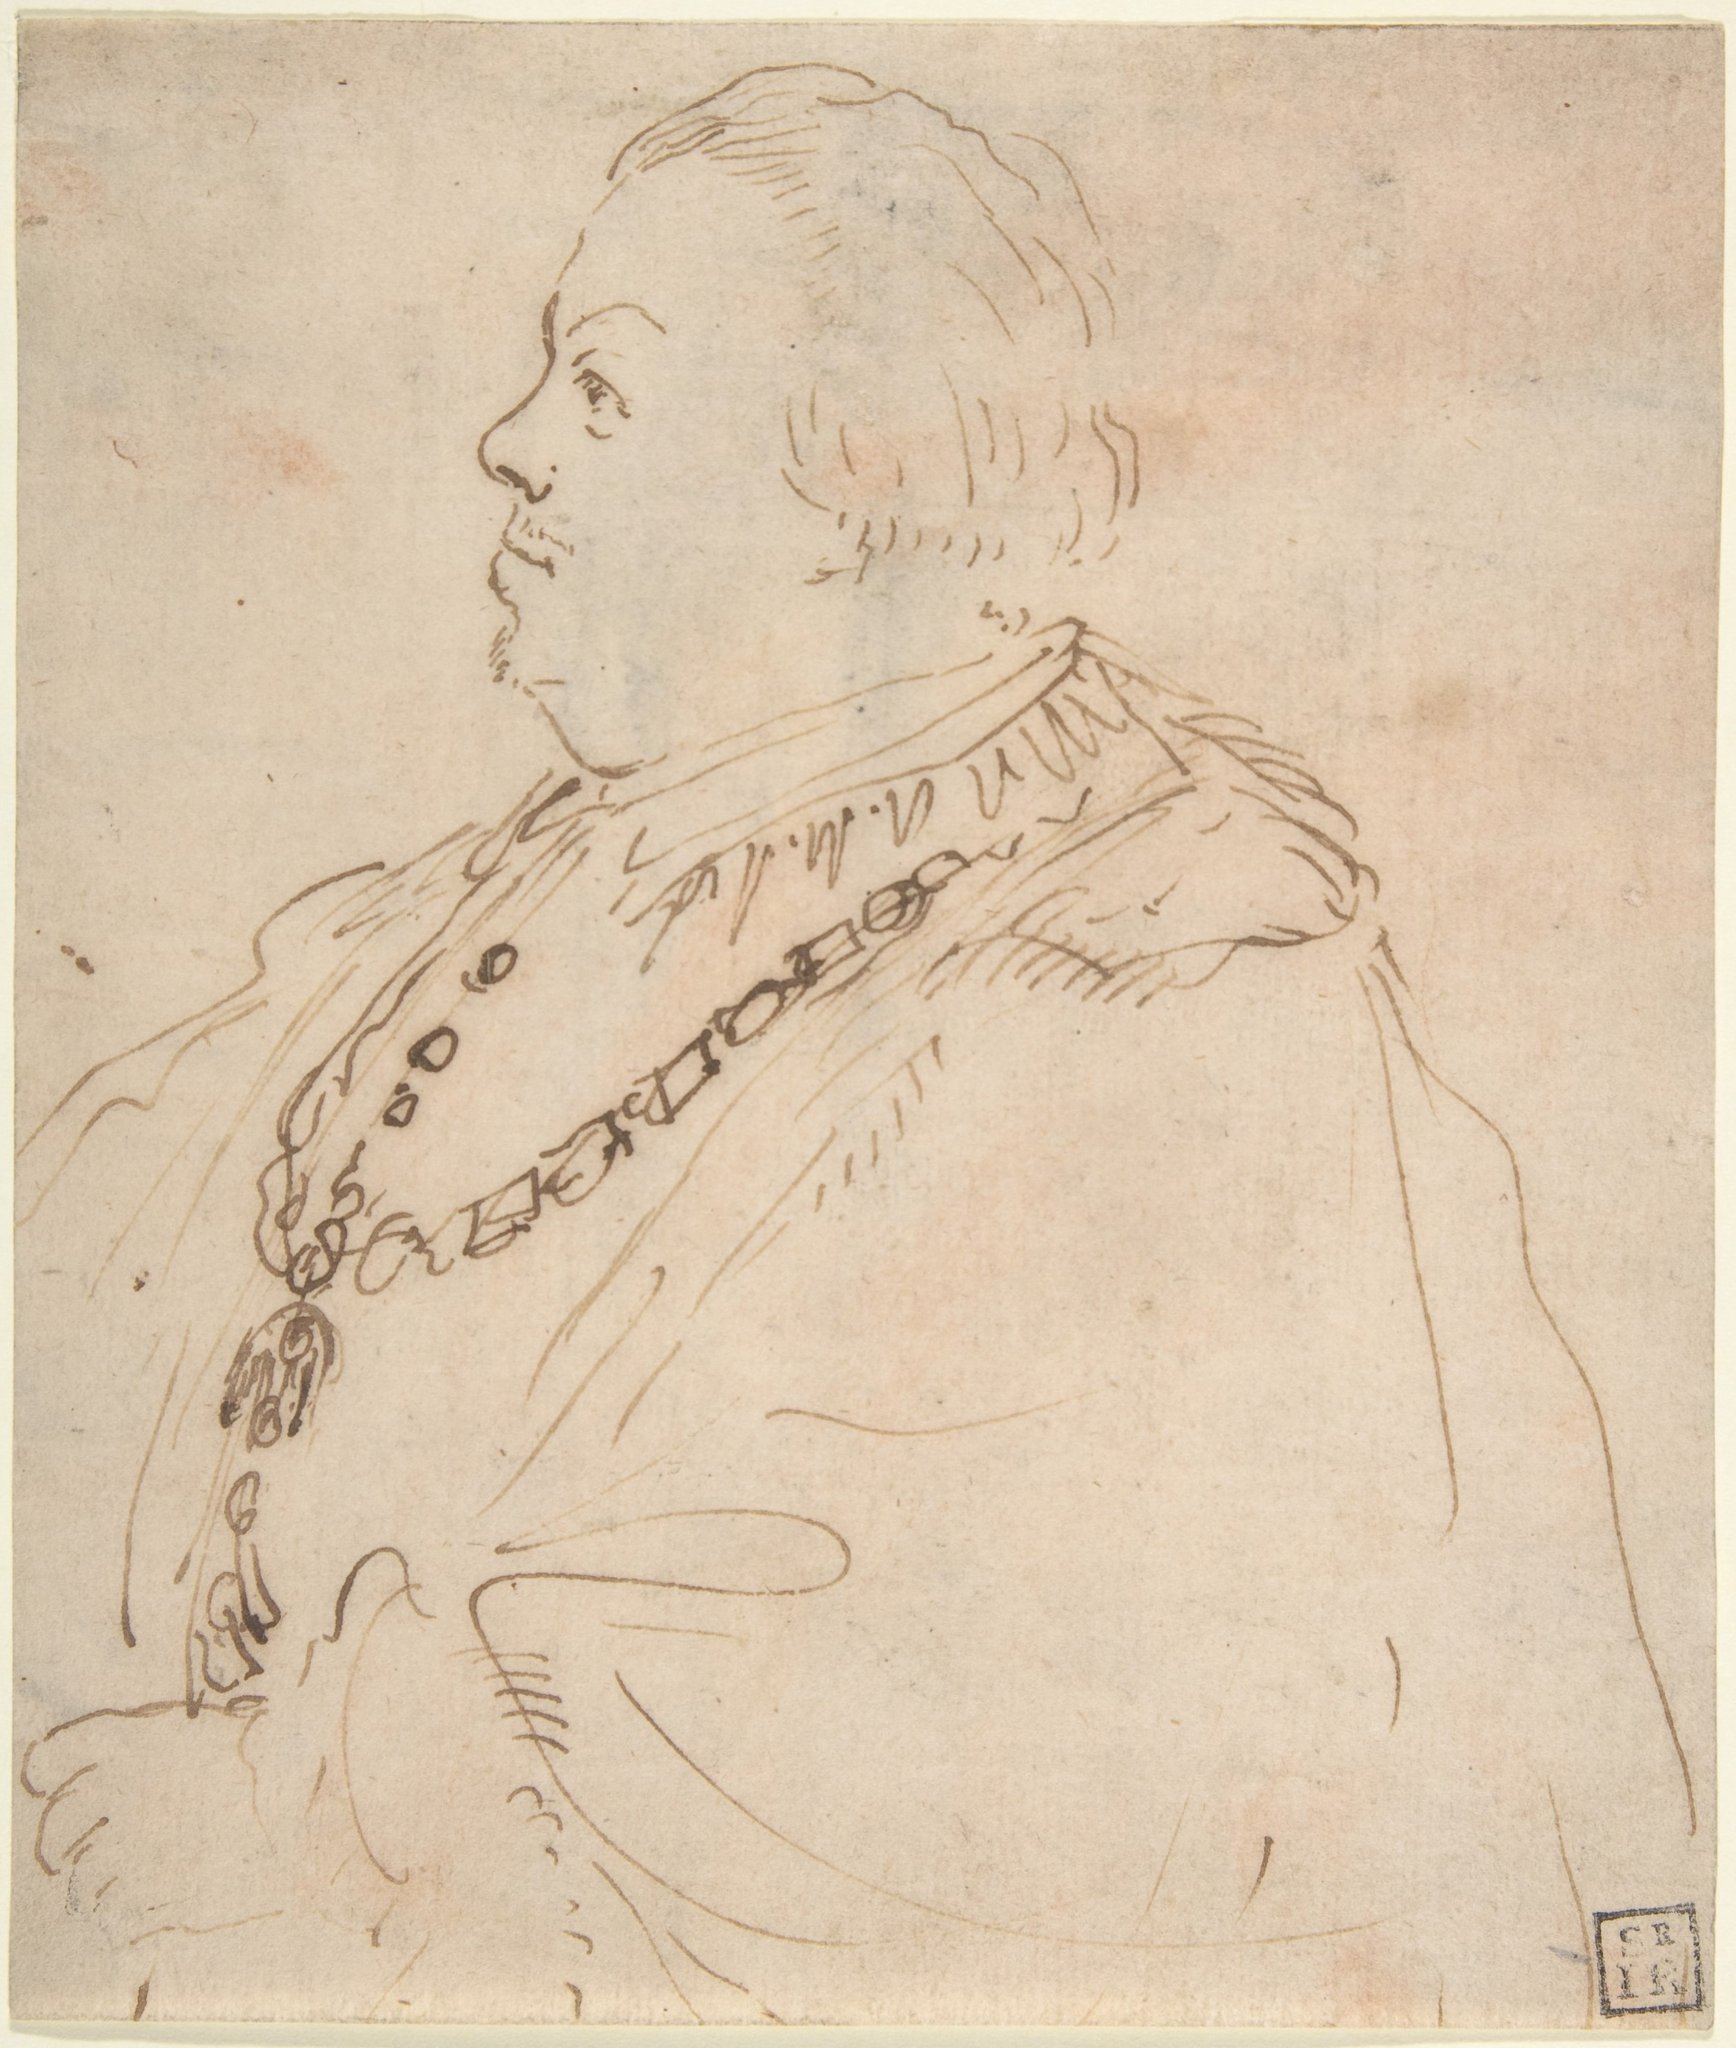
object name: drawing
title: Waist-Length Portrait of a Man Wearing the Order of the Golden Fleece, in Profile Facing Left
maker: guercino (giovanni francesco barbieri)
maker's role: artist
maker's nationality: italian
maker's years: 1591-1666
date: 1620-1629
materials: chalk, ink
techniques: pen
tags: men,profiles